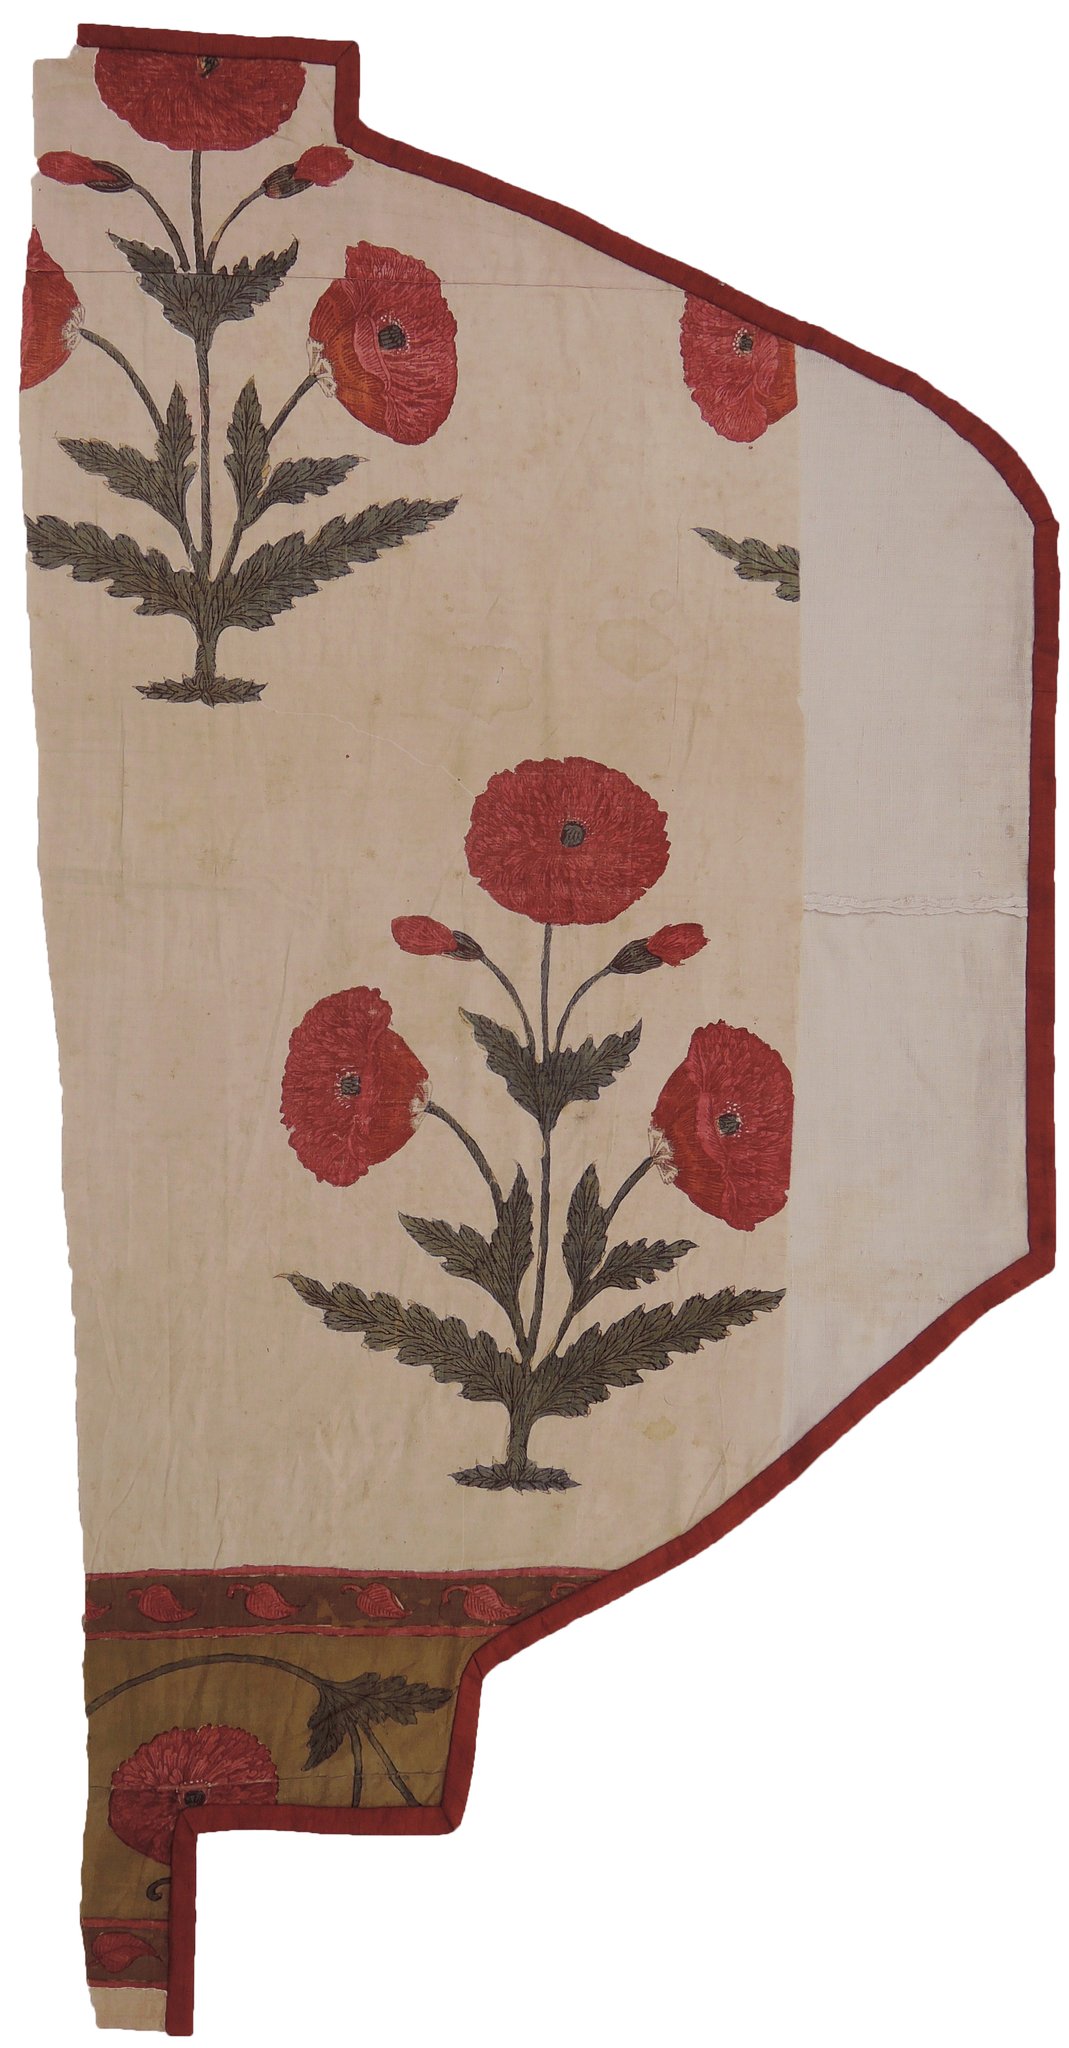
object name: textile fragment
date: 1667-1700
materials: cotton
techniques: dyeing, painting, weave, resist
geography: india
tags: flowers,leaves